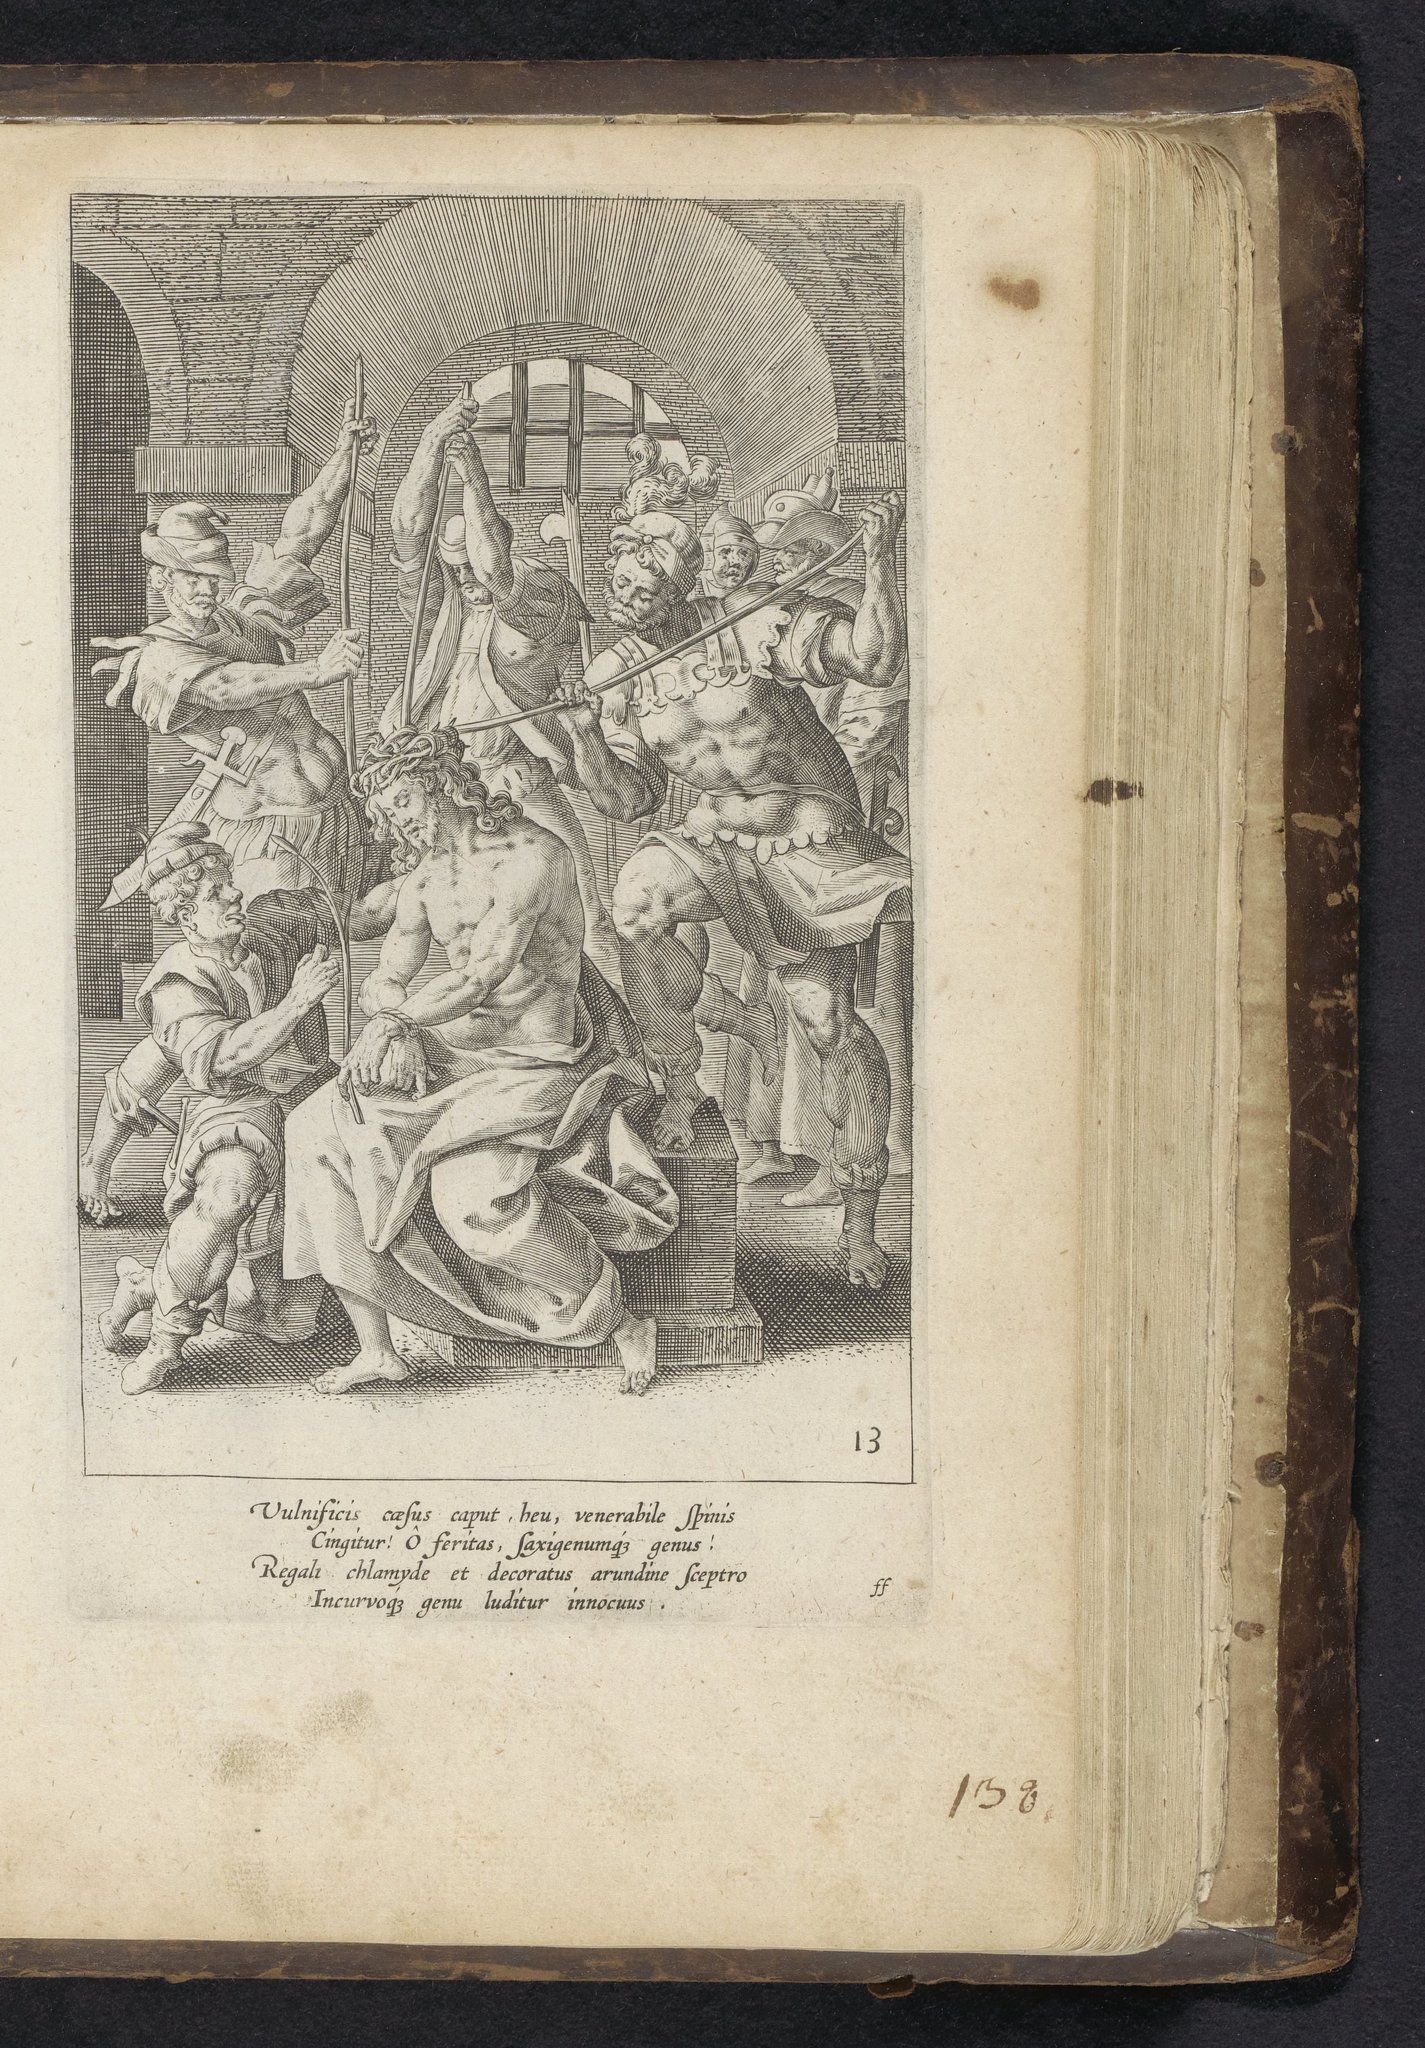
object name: album leaf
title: Van het lyden en Passie Christi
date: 1585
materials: paper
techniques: engraving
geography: amsterdam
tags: the crowning with thorns: soldiers with sticks place a thorny crown on christ's head and give him a reed (matthew 27:27-31; mark 15:16-20; john 19:2-3)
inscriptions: number: ‘138’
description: Soldaten duwen met stokken de doornenkroon op het hoofd van de met touwen geboeide Christus. Een man zit in geknielde houding voor Christus en bespot hem. Onder de voorstelling een vierregelig vers in het Latijn. Rechtsonder de letters: ff. Deze prent maakt deel uit van een album.